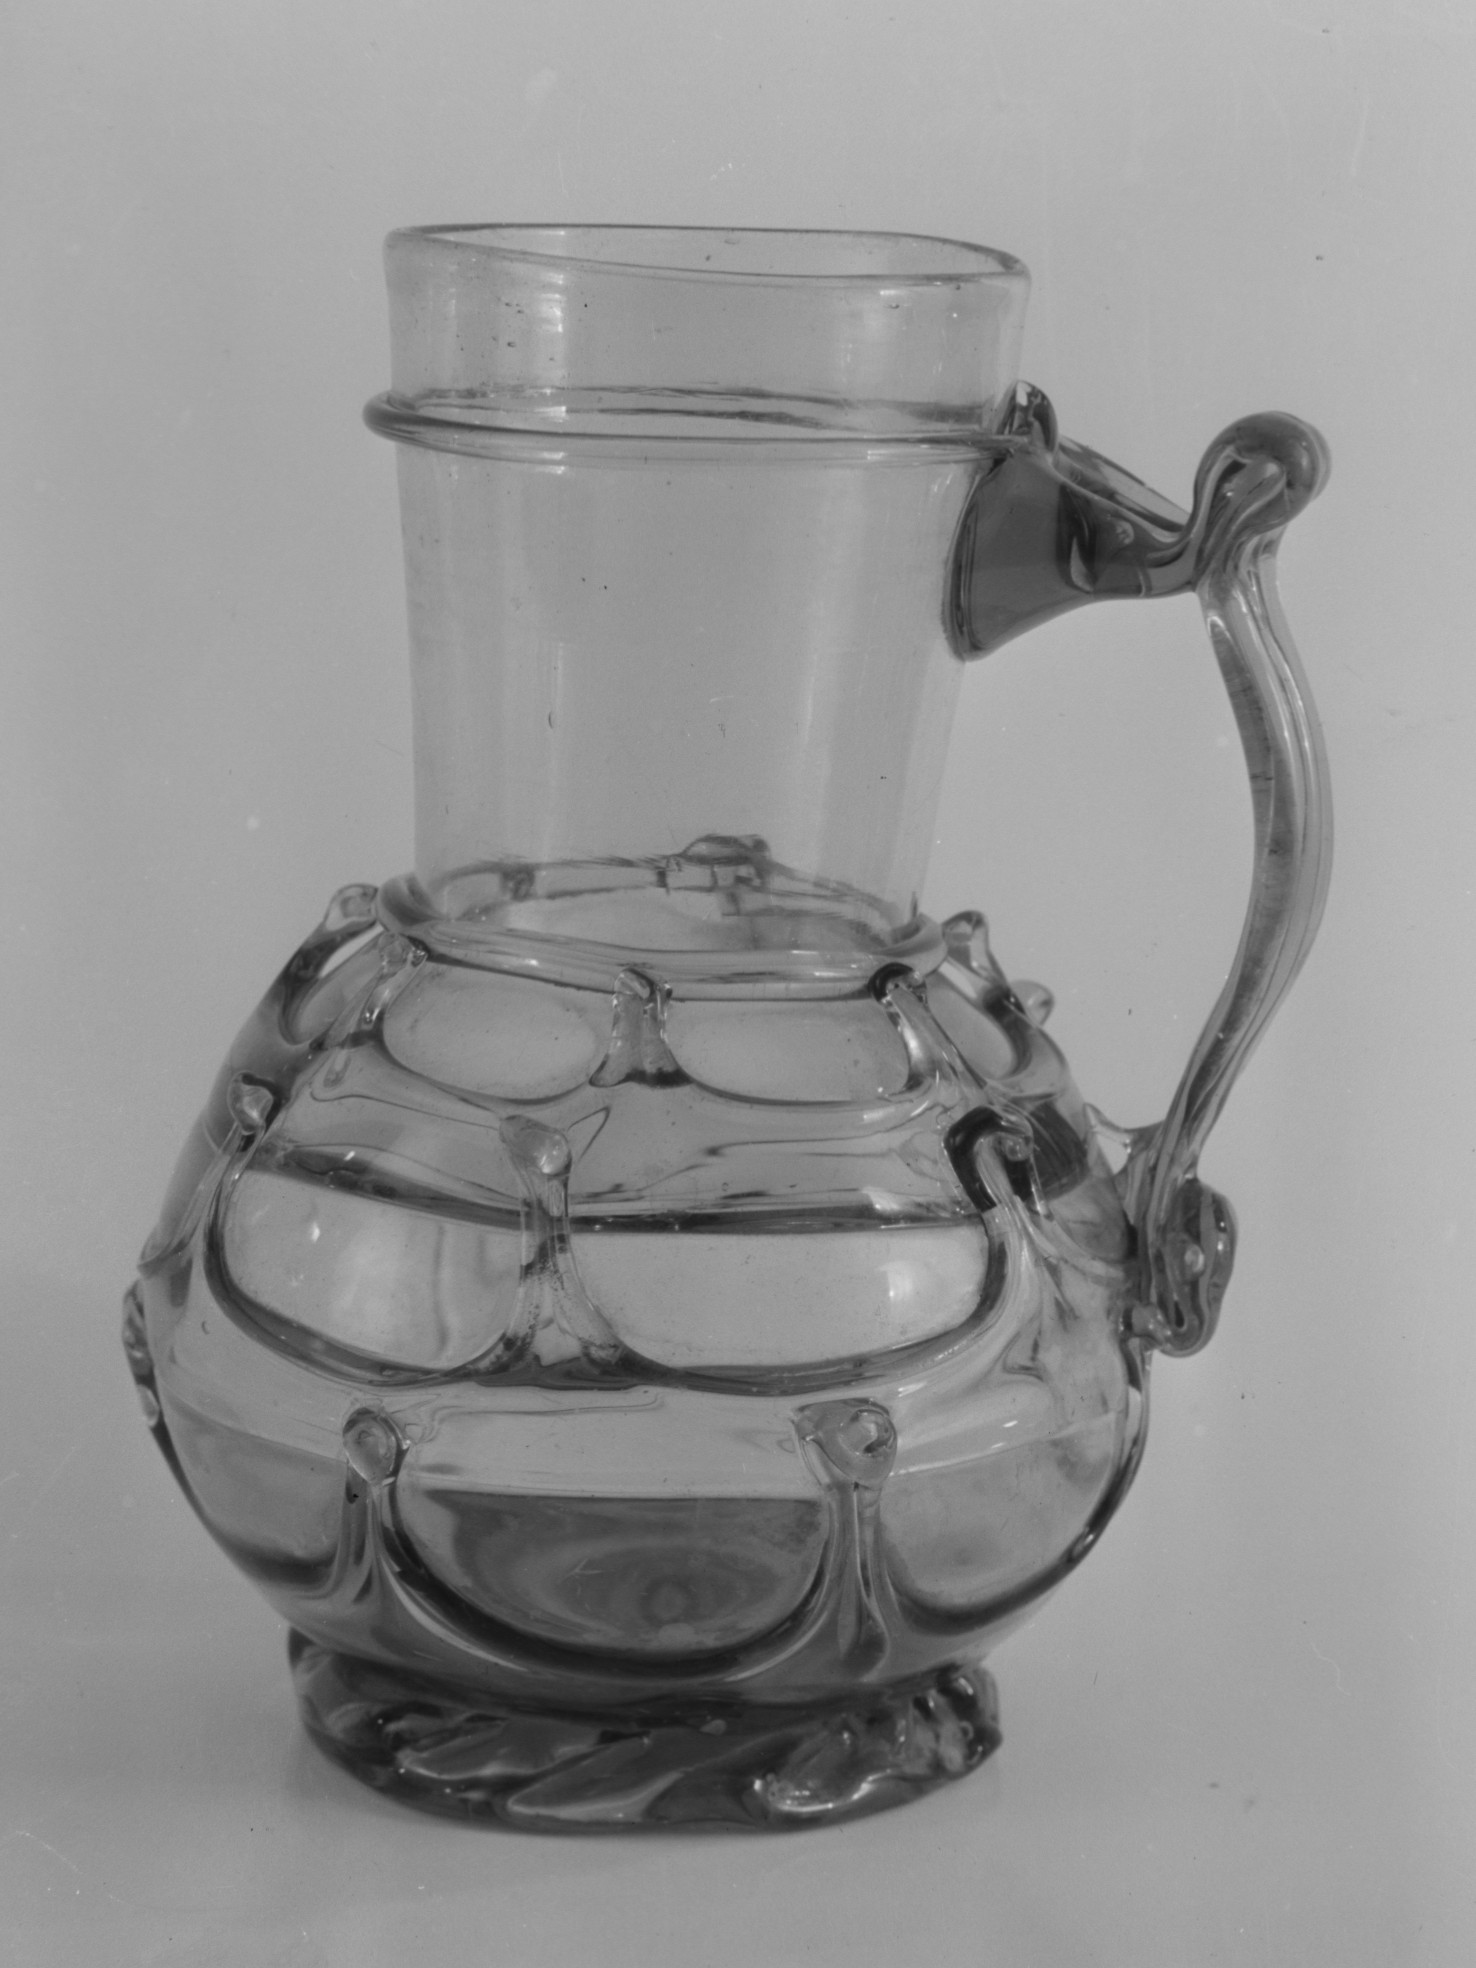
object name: jug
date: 1701-1800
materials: glass